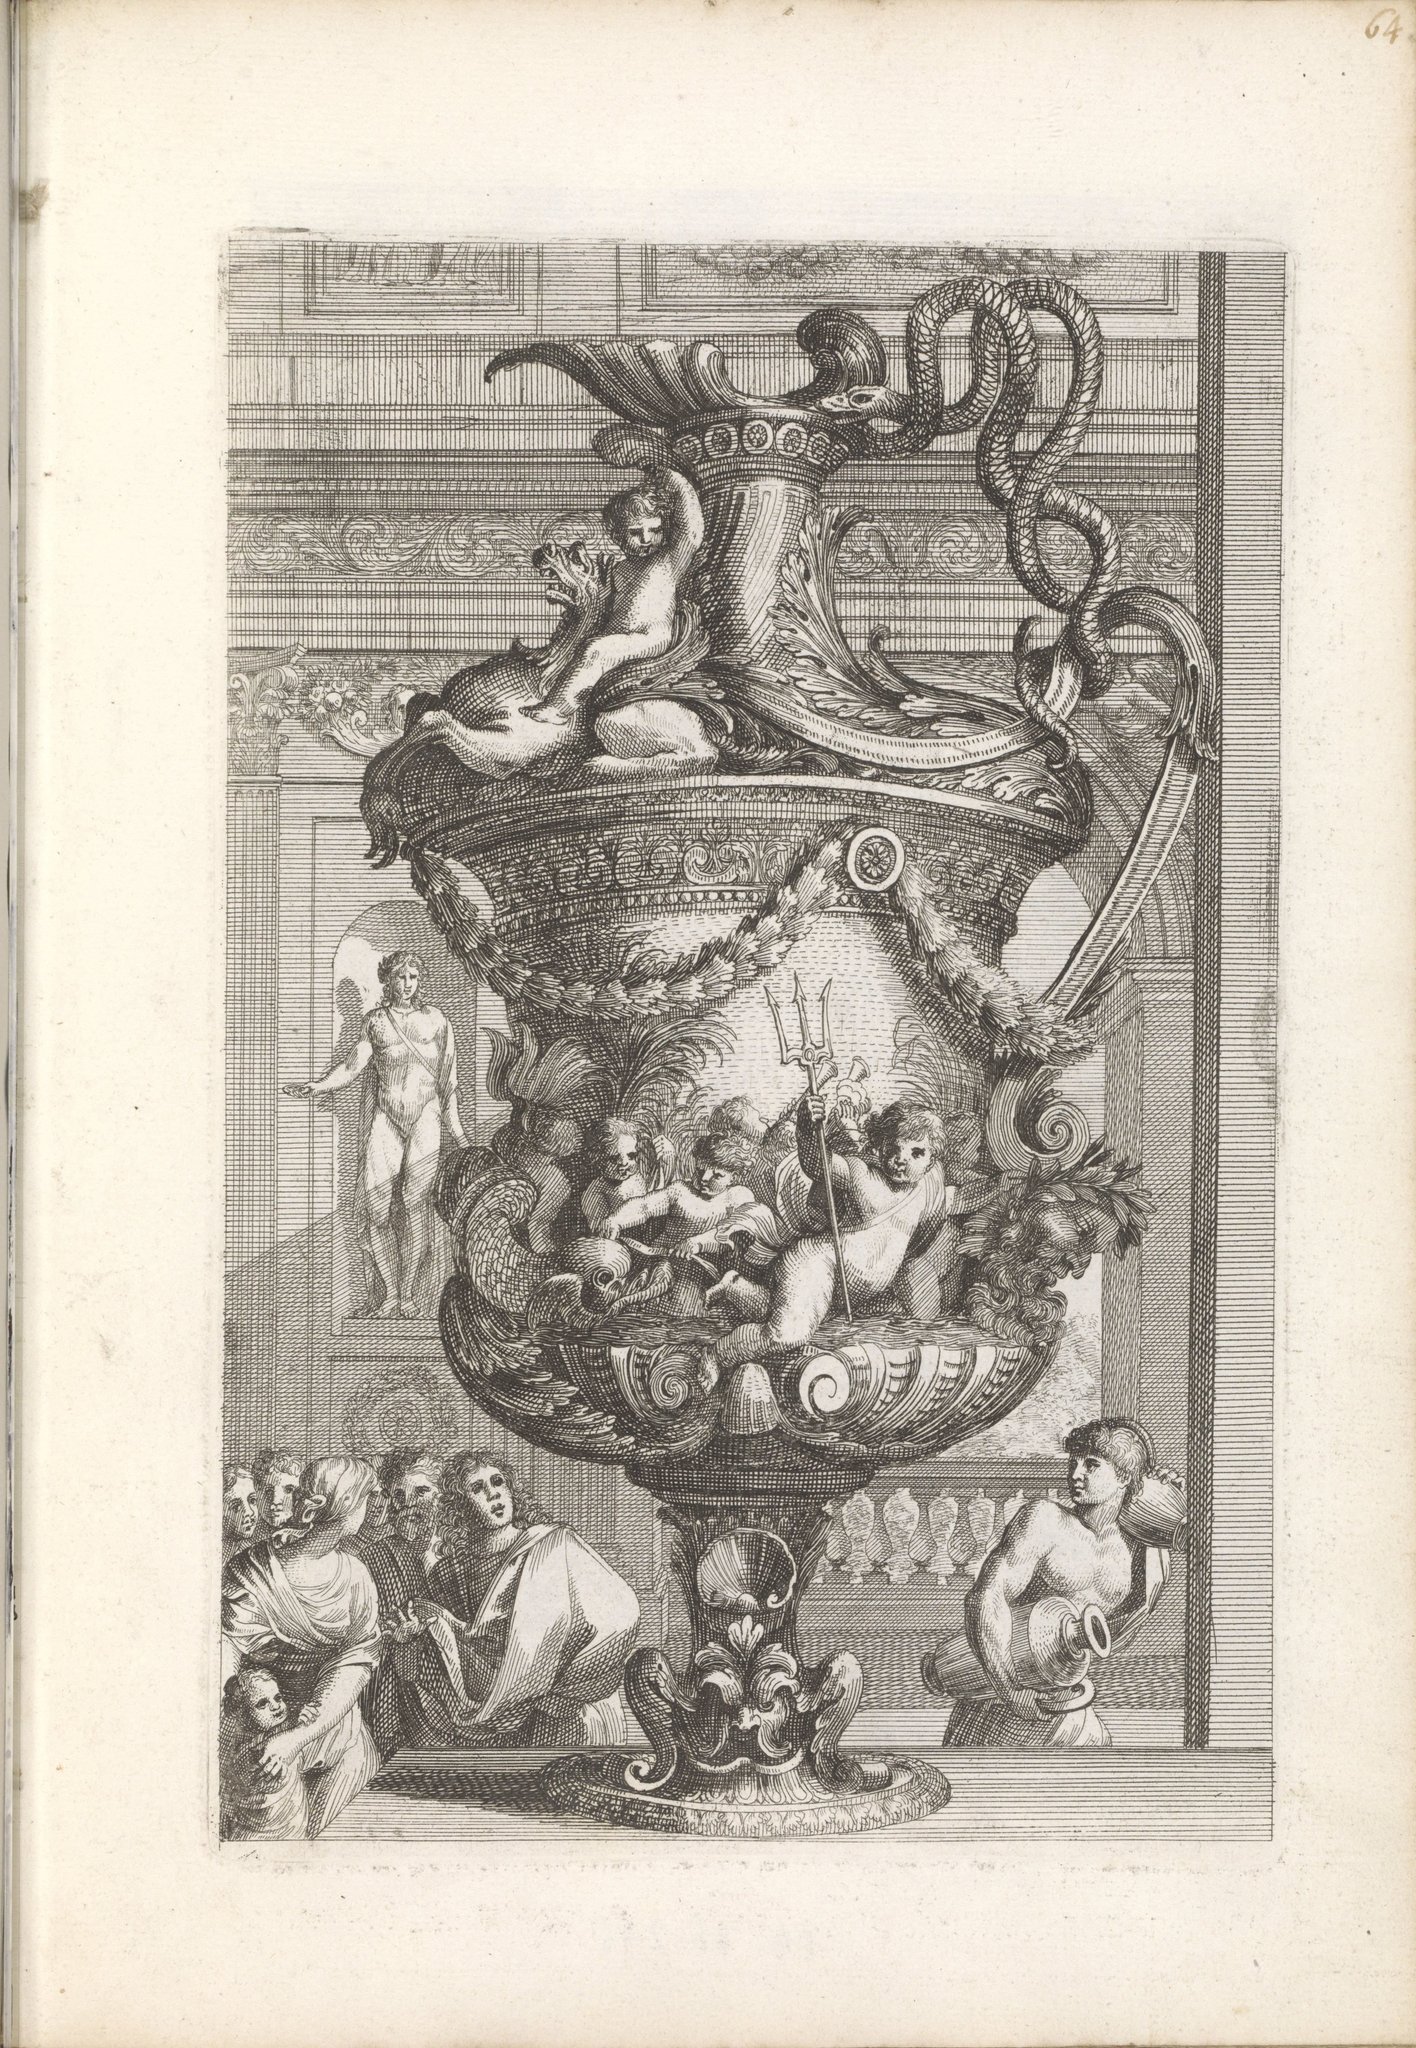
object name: ornament print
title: Schenkkan naar links gekeerd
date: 1659-1678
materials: paper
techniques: etching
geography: paris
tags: ornaments ~ art, dragon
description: De kan heeft een handvat in de vorm van twee slangen, op het lichaam spelen kinderen met een dolfijntje. Kopie naar een prent in de serie Vases à la moderne. Prent maakt deel uit van een album.